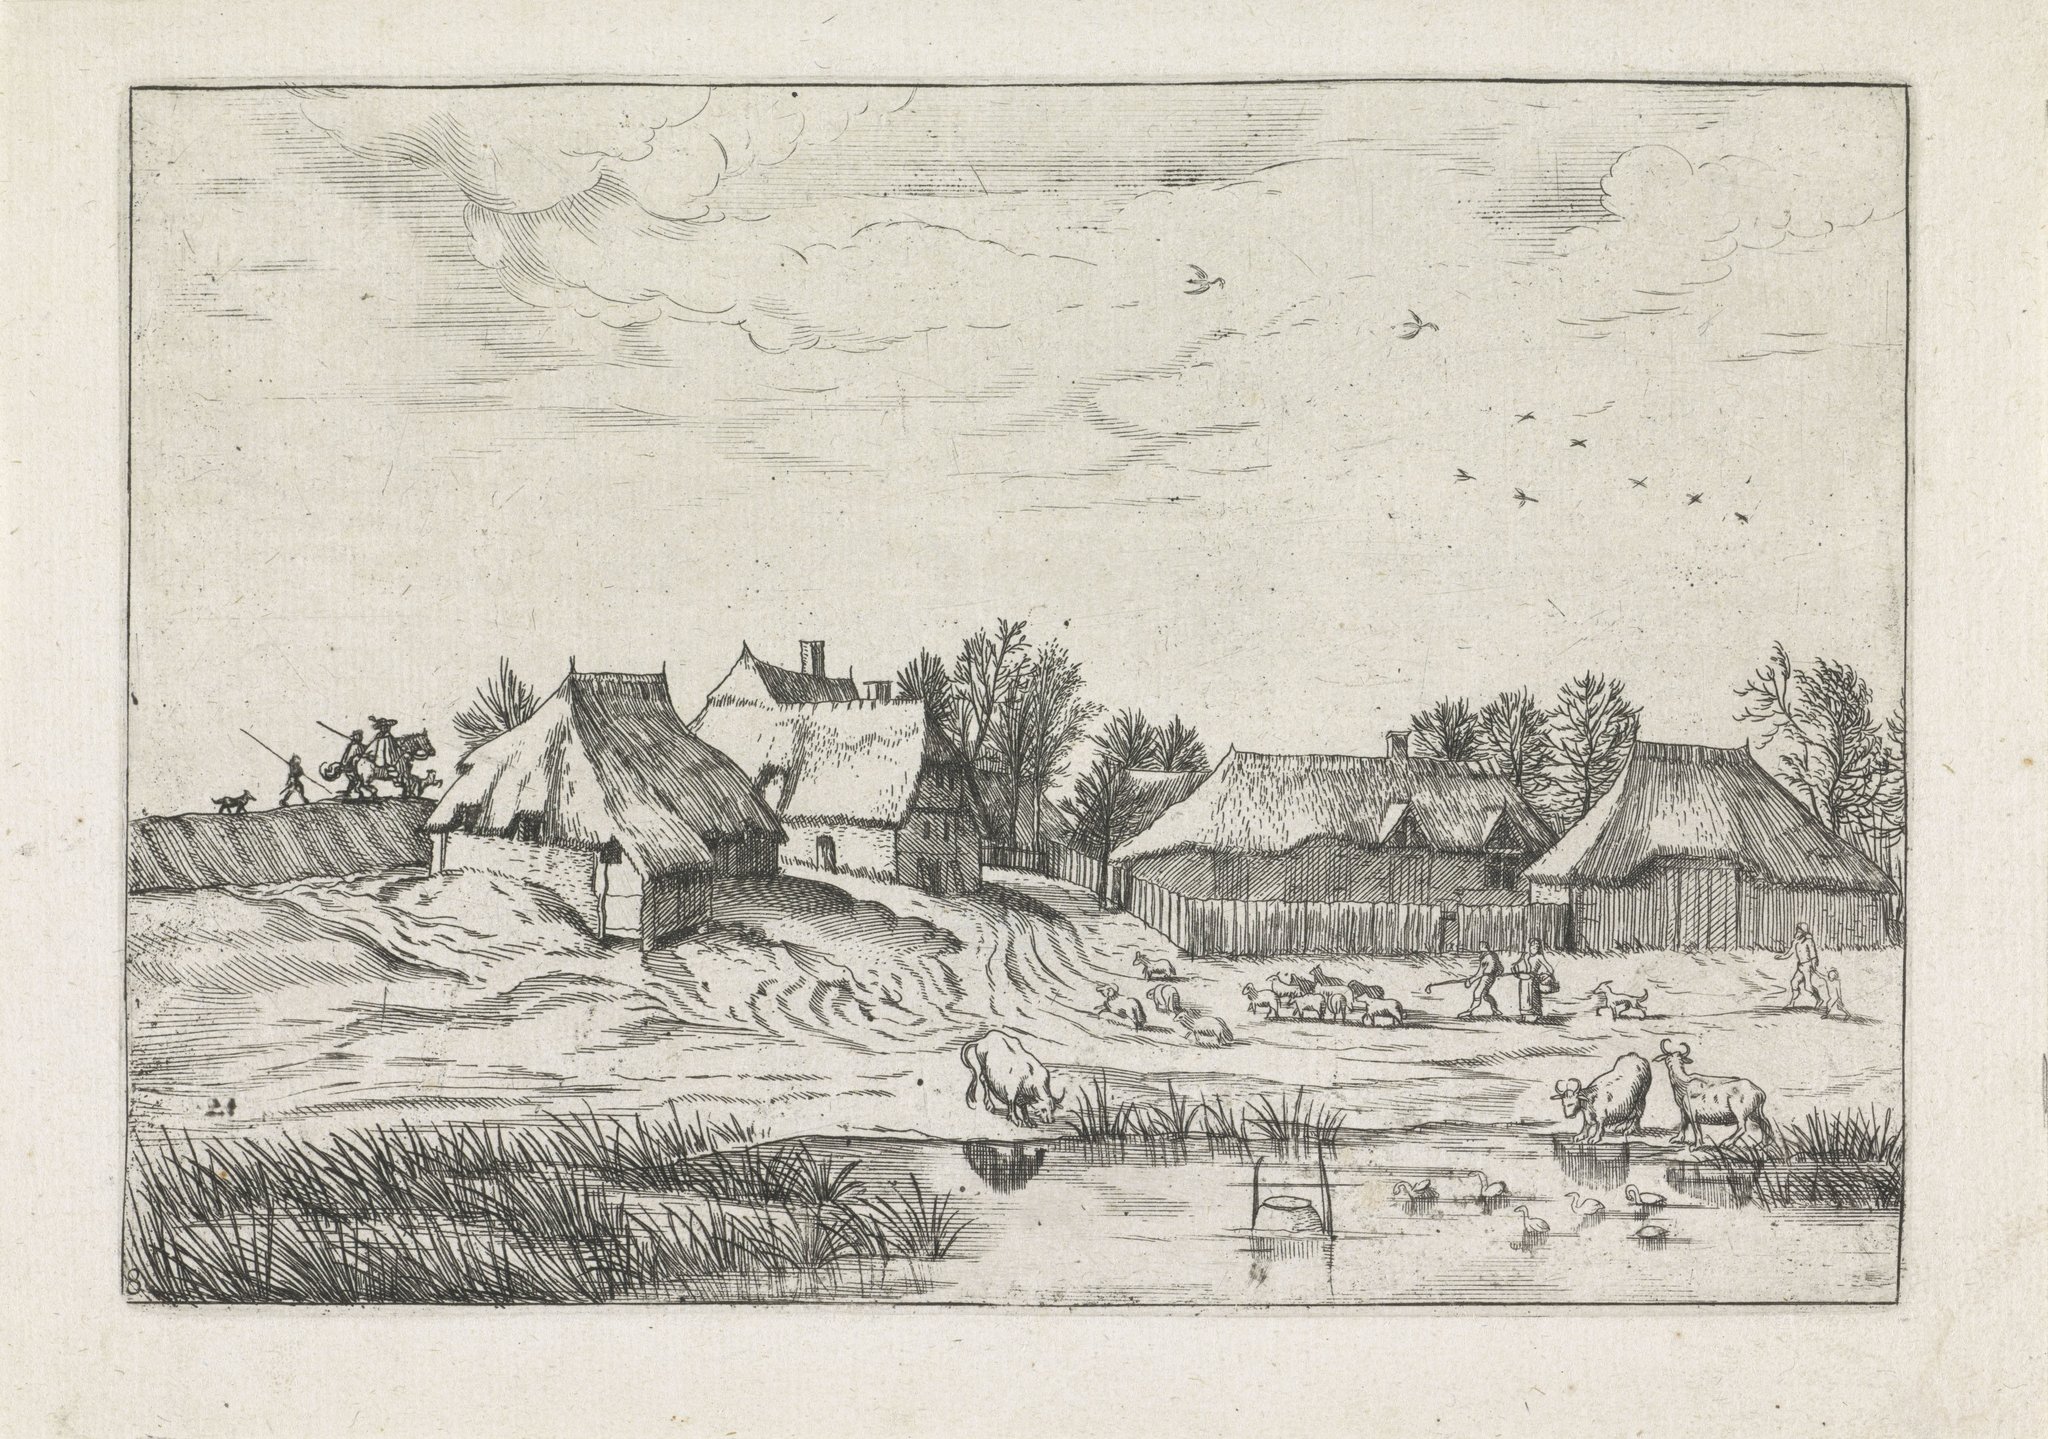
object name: print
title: Boerderijen met op de voorgrond drinkende koeien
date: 1559-1561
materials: paper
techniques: etching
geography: antwerp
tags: farm (building)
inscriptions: collector's mark: Lugt 2228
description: Boerderijen met op de voorgrond koeien bij een waterplas en een boer met een kudde vee.